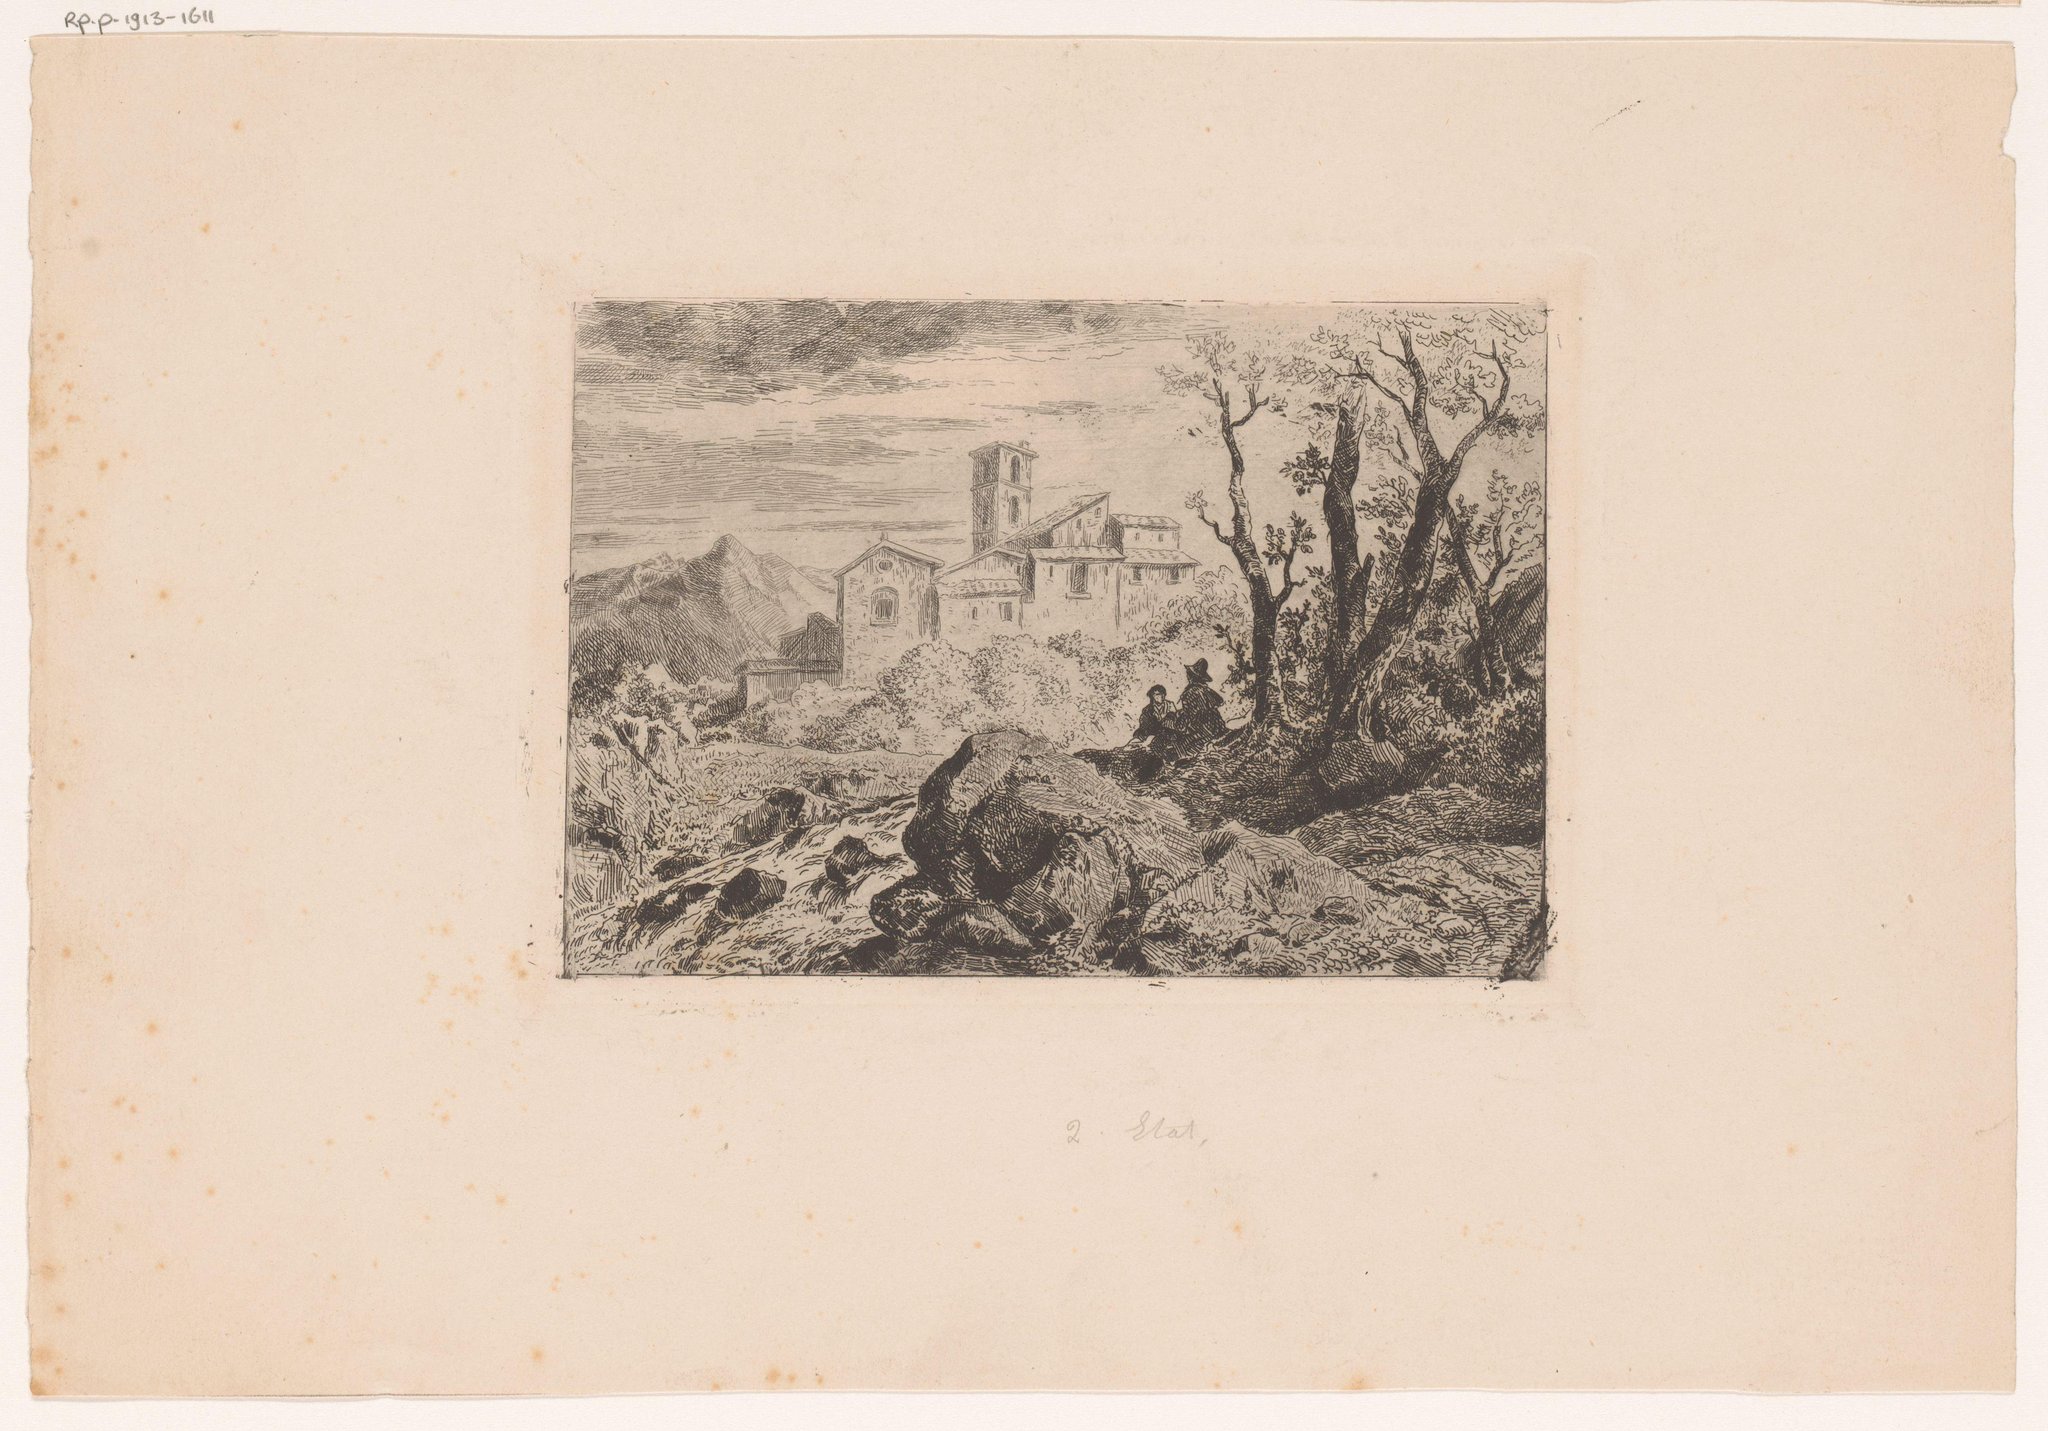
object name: print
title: Italiaans landschap met twee figuren op een rots en een klooster op de achtergrond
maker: joseph meganck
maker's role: print maker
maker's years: 1807-1891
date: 1817-1888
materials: paper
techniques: etching, intaglio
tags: abbey, monastery, convent ~ roman catholic church, landscapes (+ landscape with figures, staffage), rocks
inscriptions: inscription: ‘2 Etat’, collector's mark: Lugt 2228